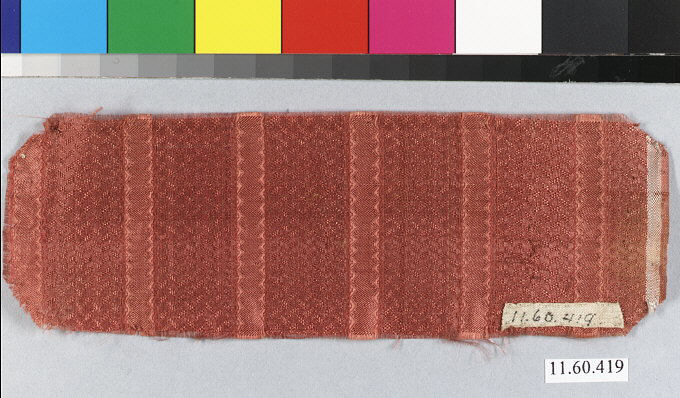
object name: fragment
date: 1801-1900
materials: silk